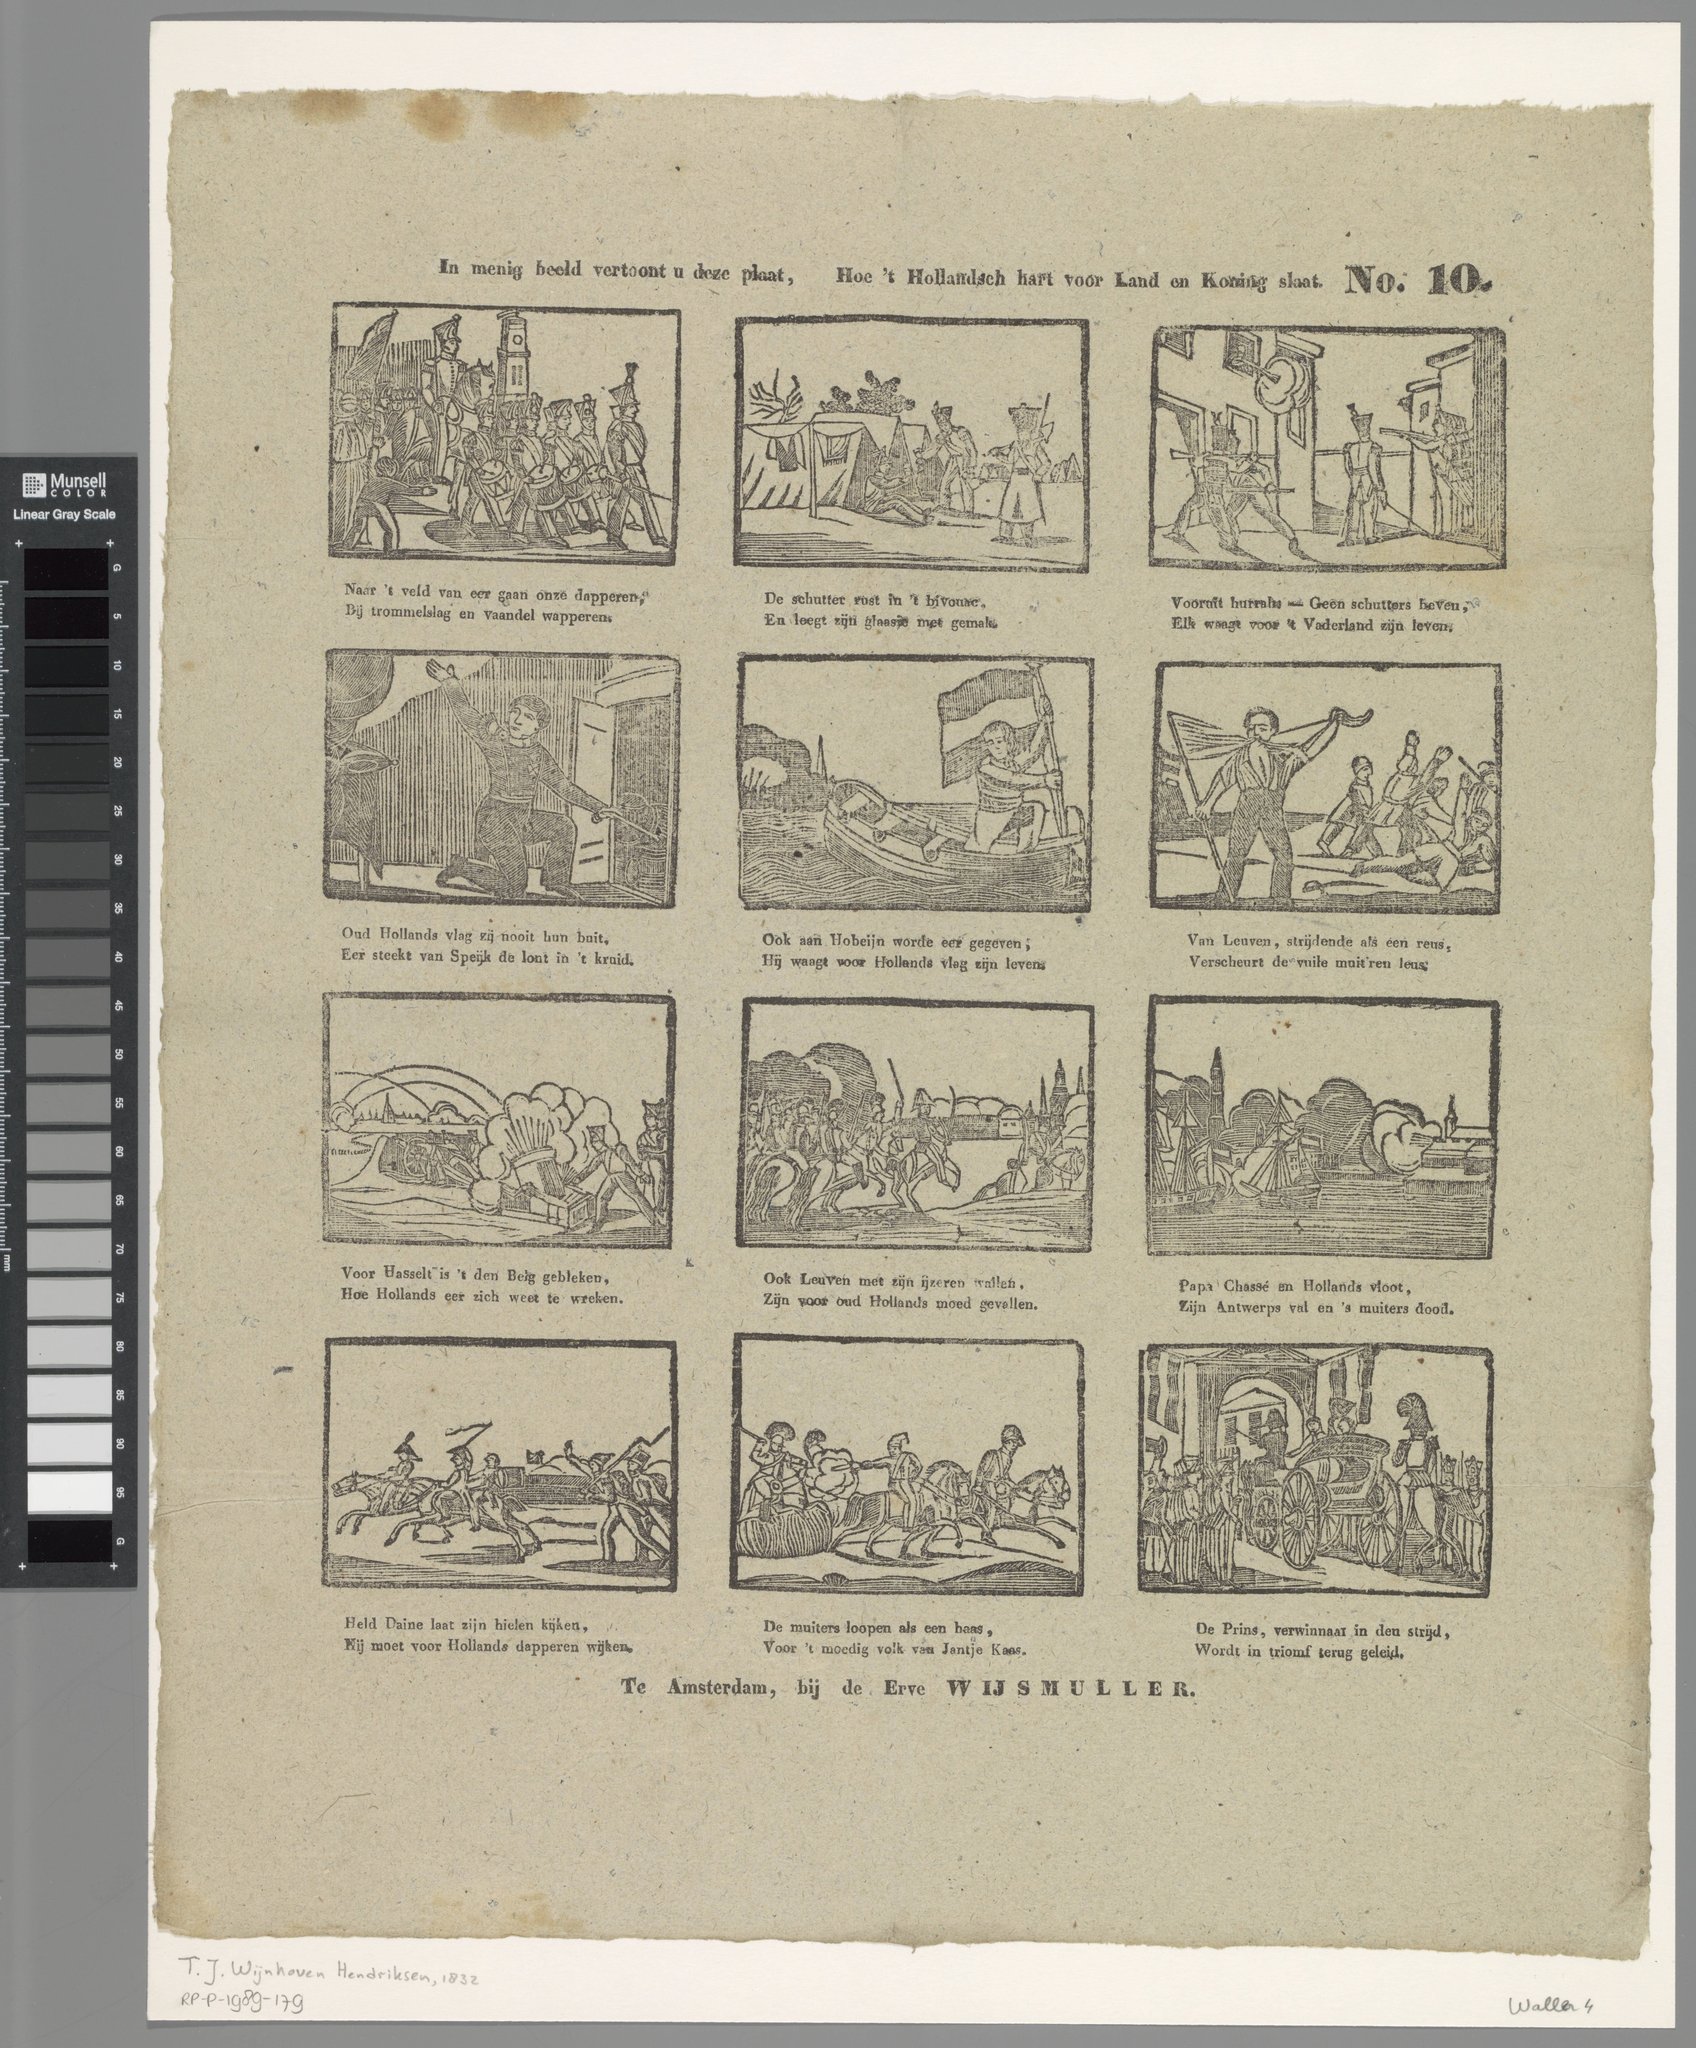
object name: print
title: In menig beeld vertoont u deze plaat, / Hoe 't Hollandsch hart voor land en koning slaat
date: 1832-1850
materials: paper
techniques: letterpress printing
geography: amsterdam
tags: military band, battle, weapons, warfare; military affairs (+ cavalry, horsemen), the soldier; the soldier's life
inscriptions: collector's mark: Lugt 2760, collector's mark: Lugt 2228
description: Blad met 12 voorstellingen van militairen in strijd. Onder elke voorstelling een tweeregelig vers. Genummerd rechtsboven: No. 10.